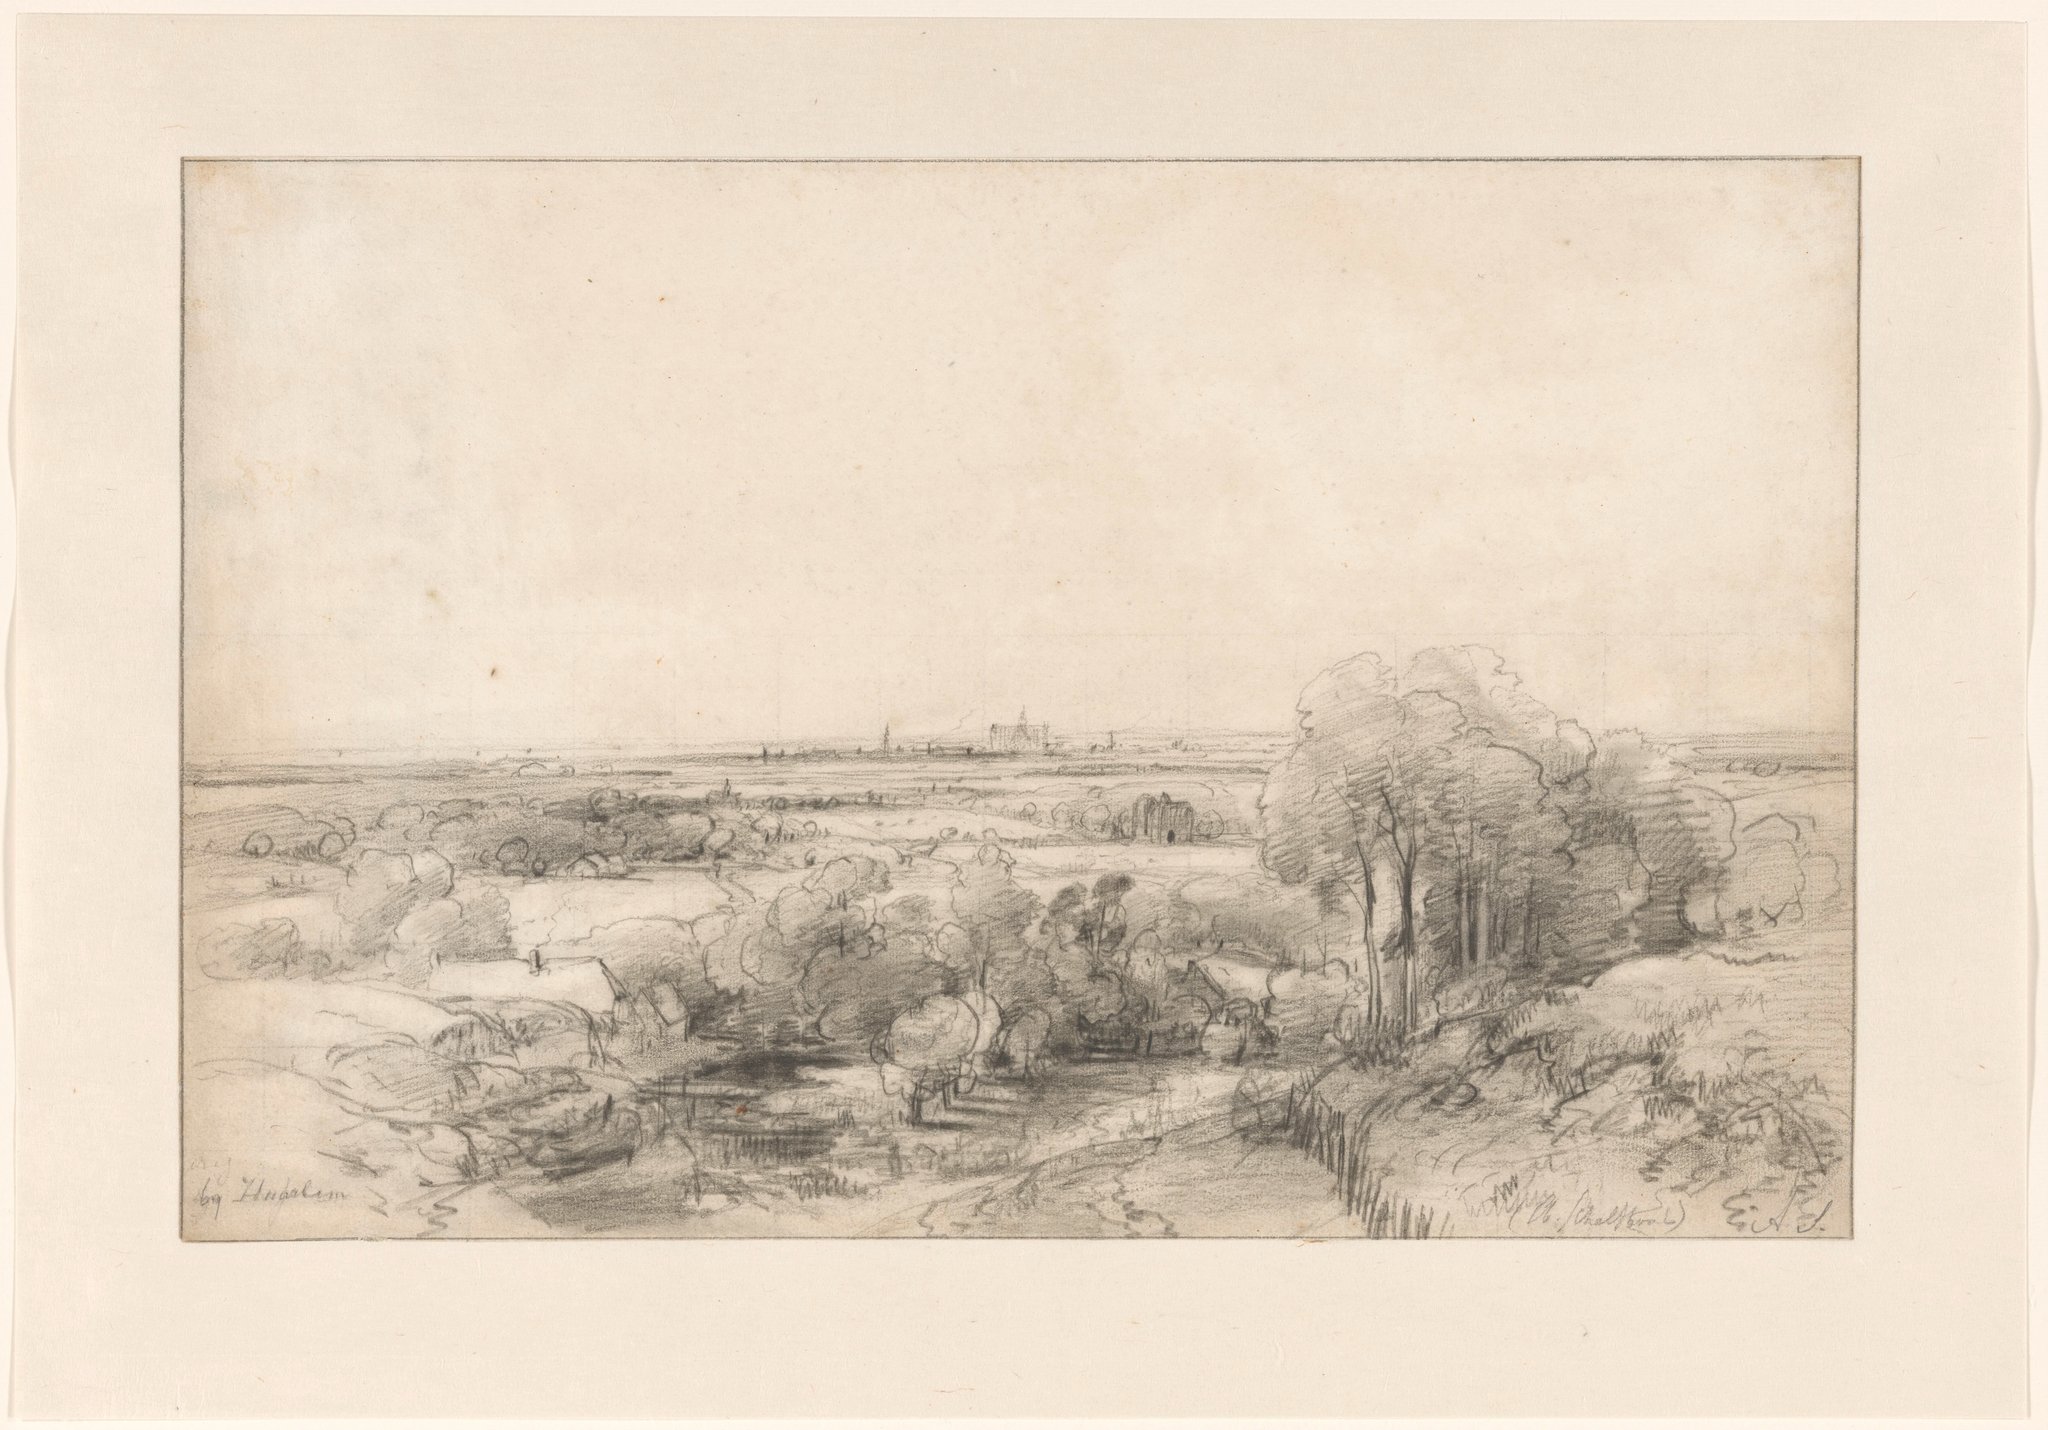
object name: drawing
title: Panoramisch gezicht op Haarlem en de ruïne van Brederode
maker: andreas schelfhout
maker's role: draughtsman, painter, print maker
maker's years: 1787-1870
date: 1839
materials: chalk, paper, pencil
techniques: drawing, stumping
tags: haarlem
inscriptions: signature: ‘A.S.’, annotation: ‘by Haarlem’, signature: ‘A. Schelfhout’, annotation: ‘(A.Schelfhout)’